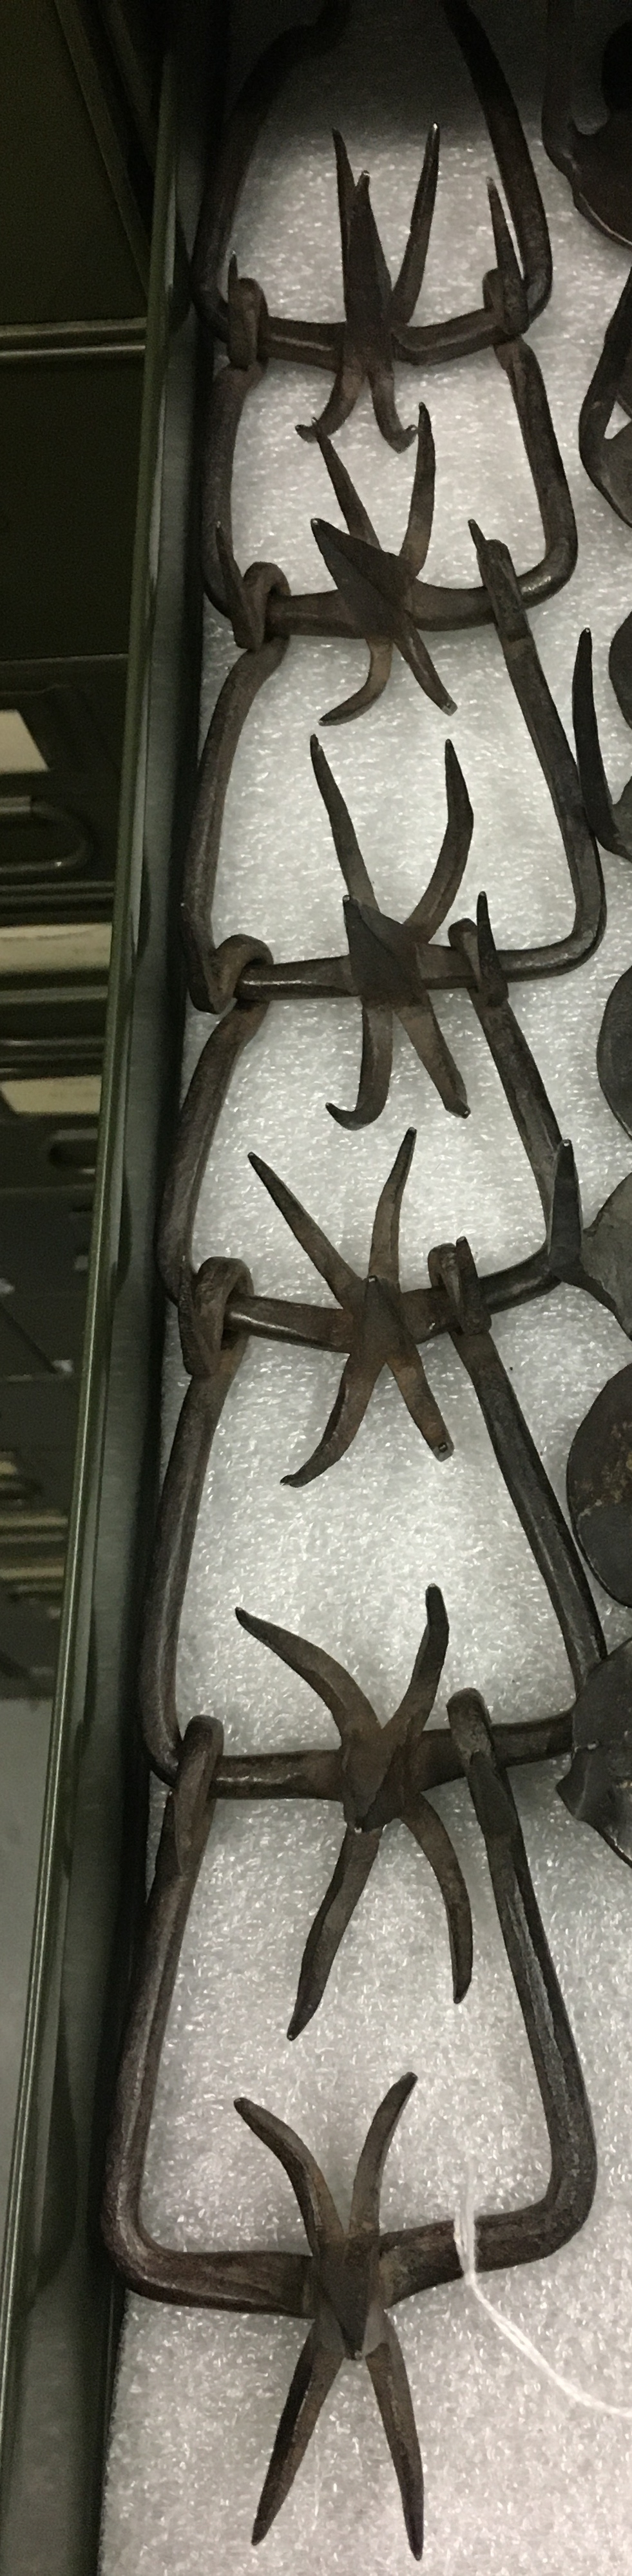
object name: collar for hunting dog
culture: german or austrian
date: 1601-1700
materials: iron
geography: germany